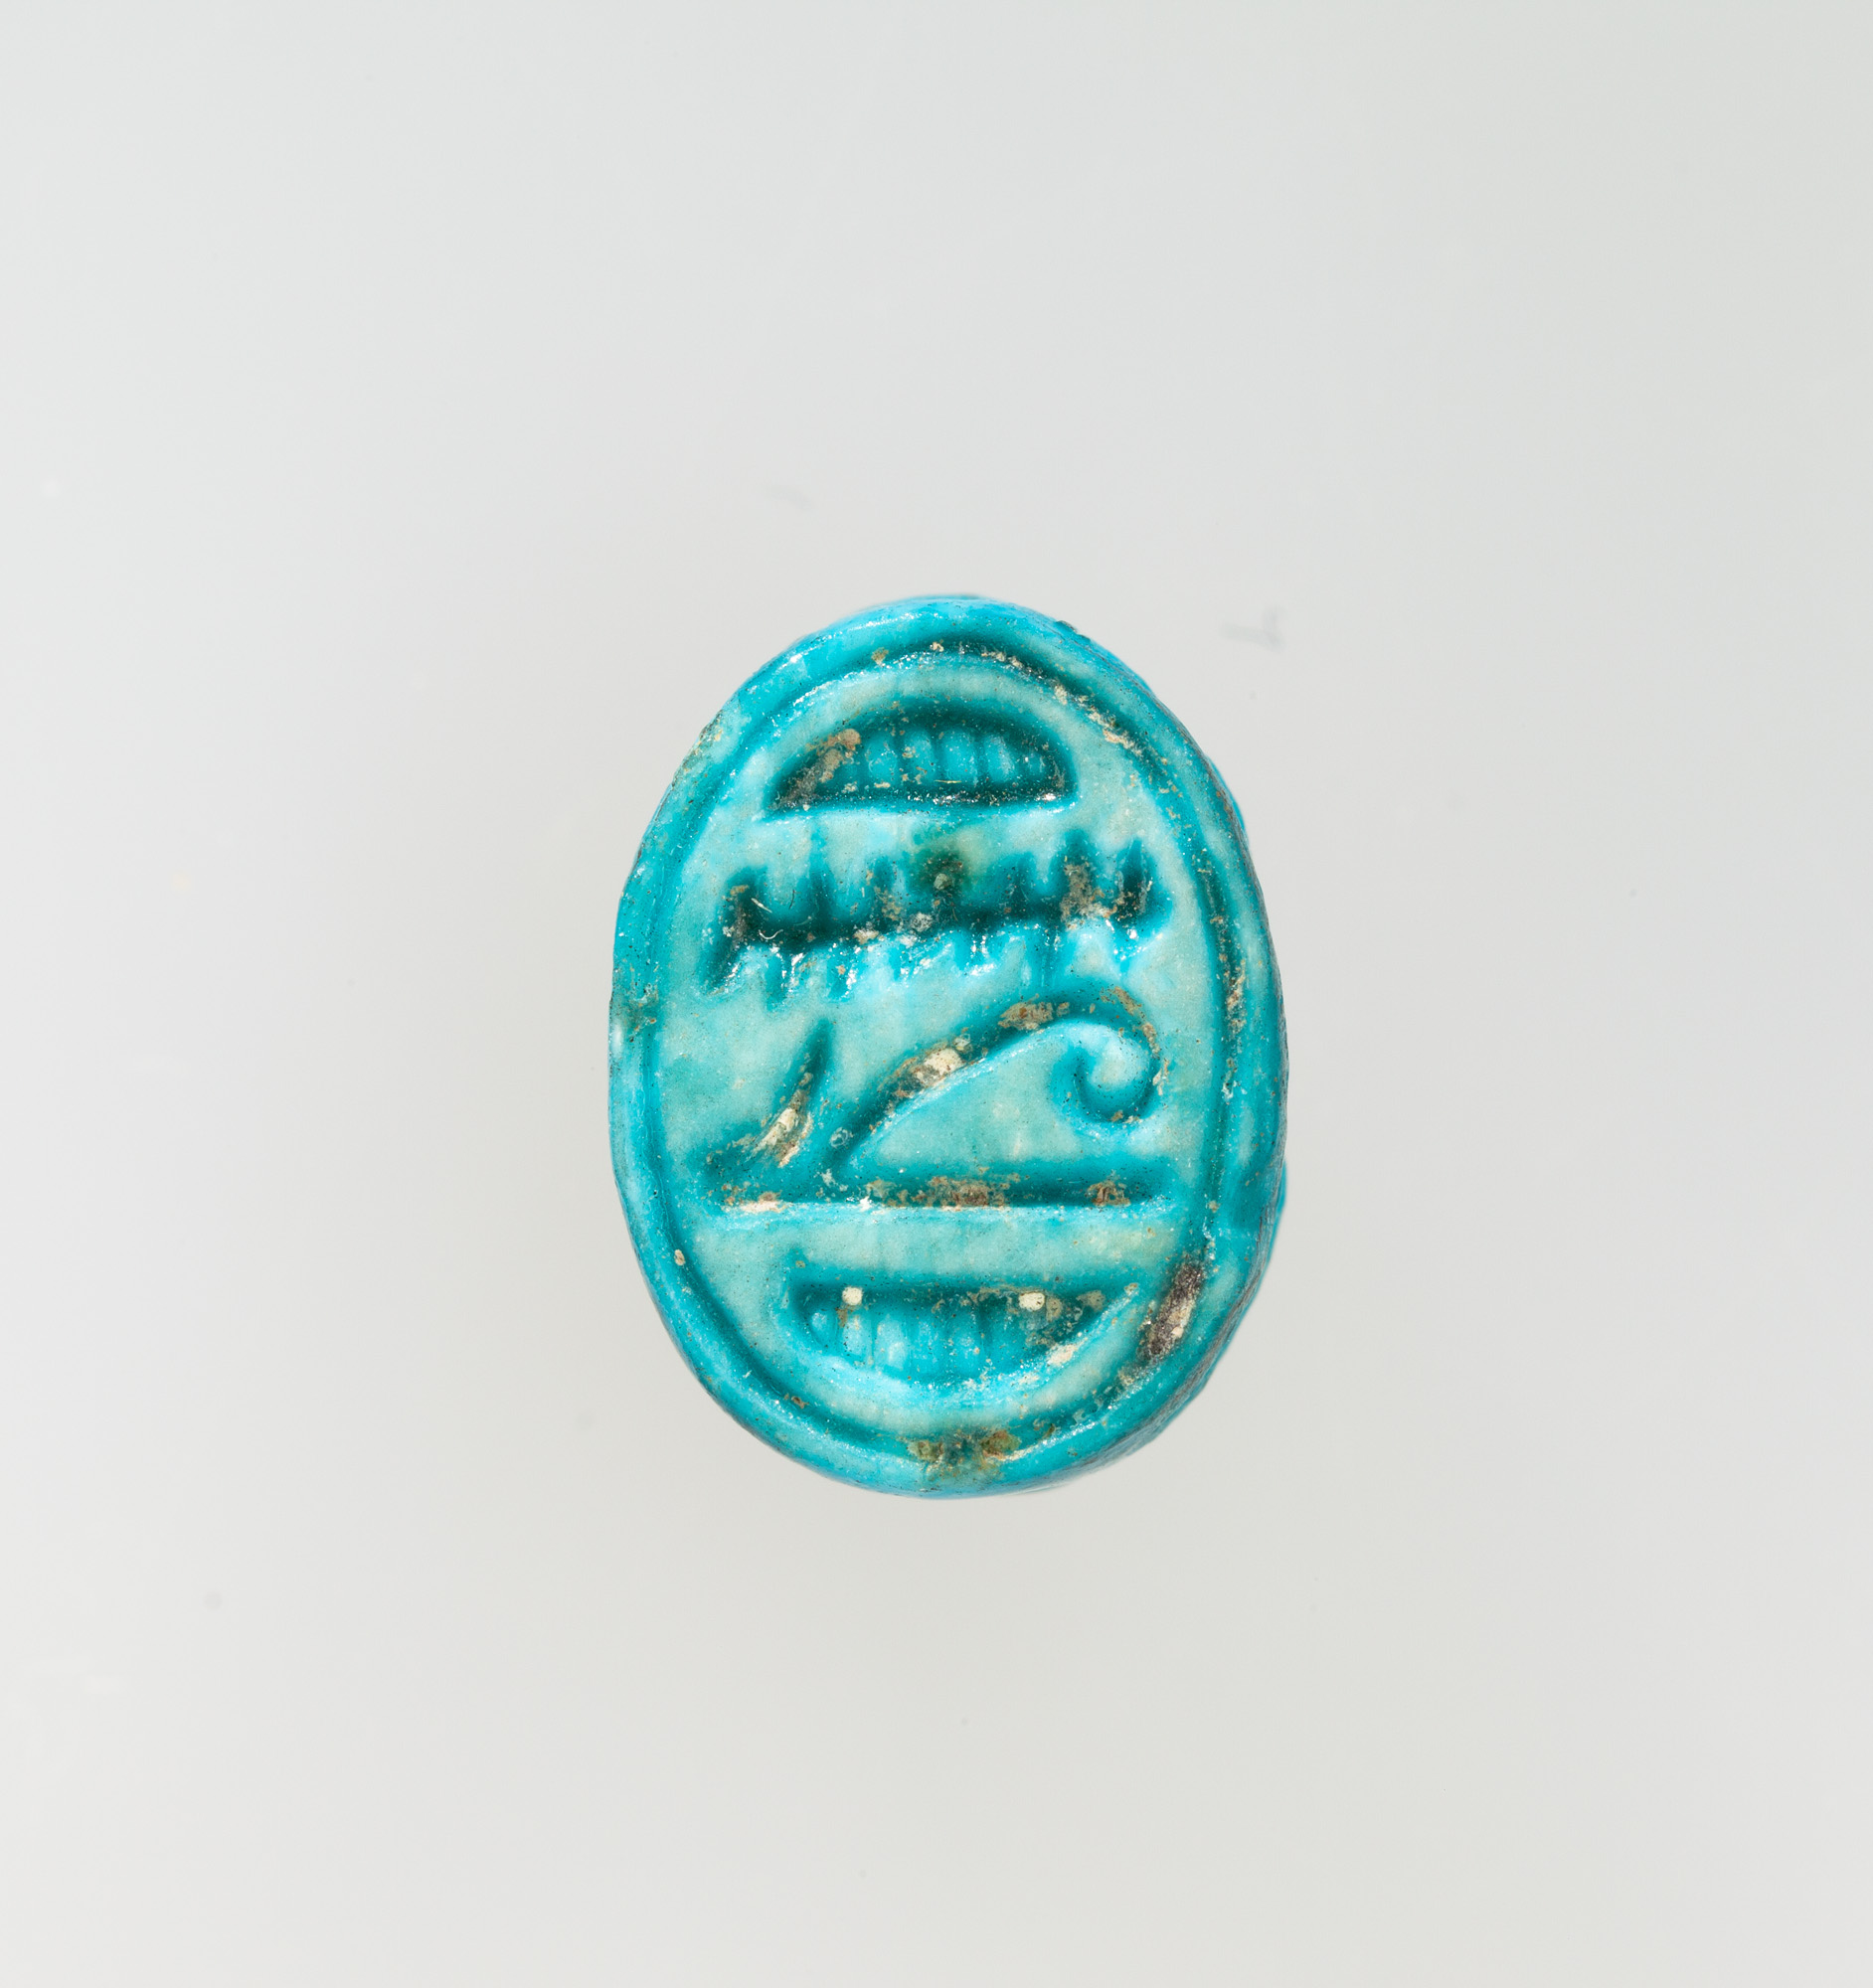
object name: scarab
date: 1479-1458 BCE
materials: faience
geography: egypt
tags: hieroglyphs,scarabs